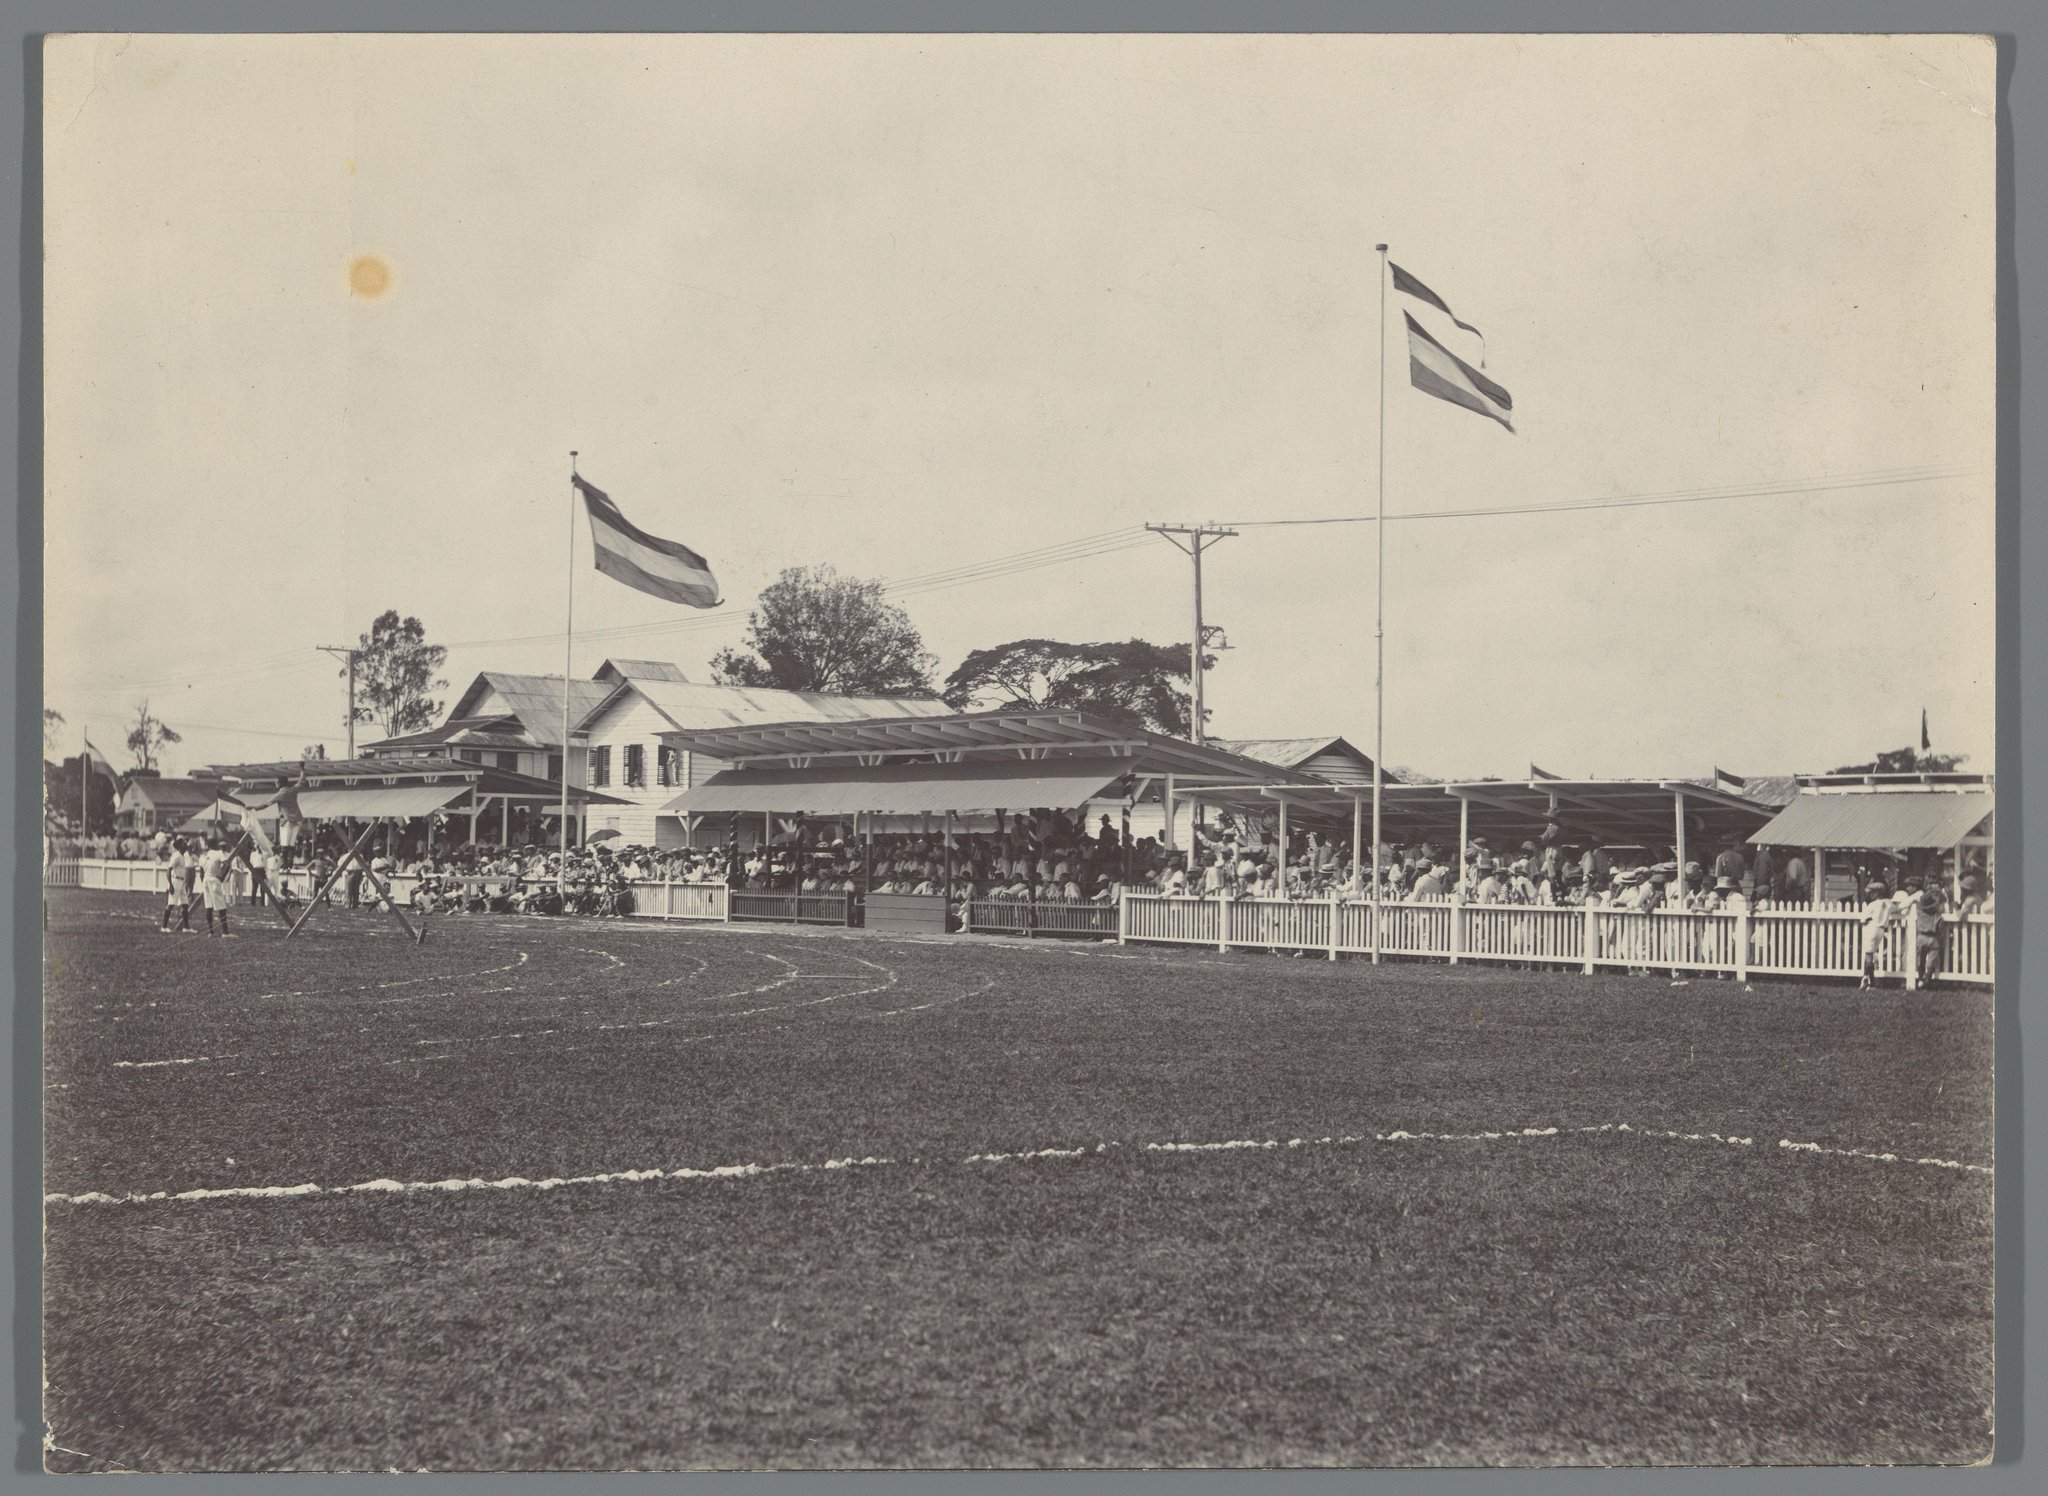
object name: photograph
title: Sportveld van Moengo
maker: Anonymous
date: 1925-1927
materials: photographic support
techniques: photography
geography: suriname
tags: jetten, familie, moengo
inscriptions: inscription: ‘Sportveld Moengo’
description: Sportevenement op het sportveld van Moengo. Met volle tribunes en wapperende Nederlandse vlaggen. Onderdeel van het ensemble met foto's van de familie van ingenieur Jetten in de mijnbouwstad Moengo in Suriname.